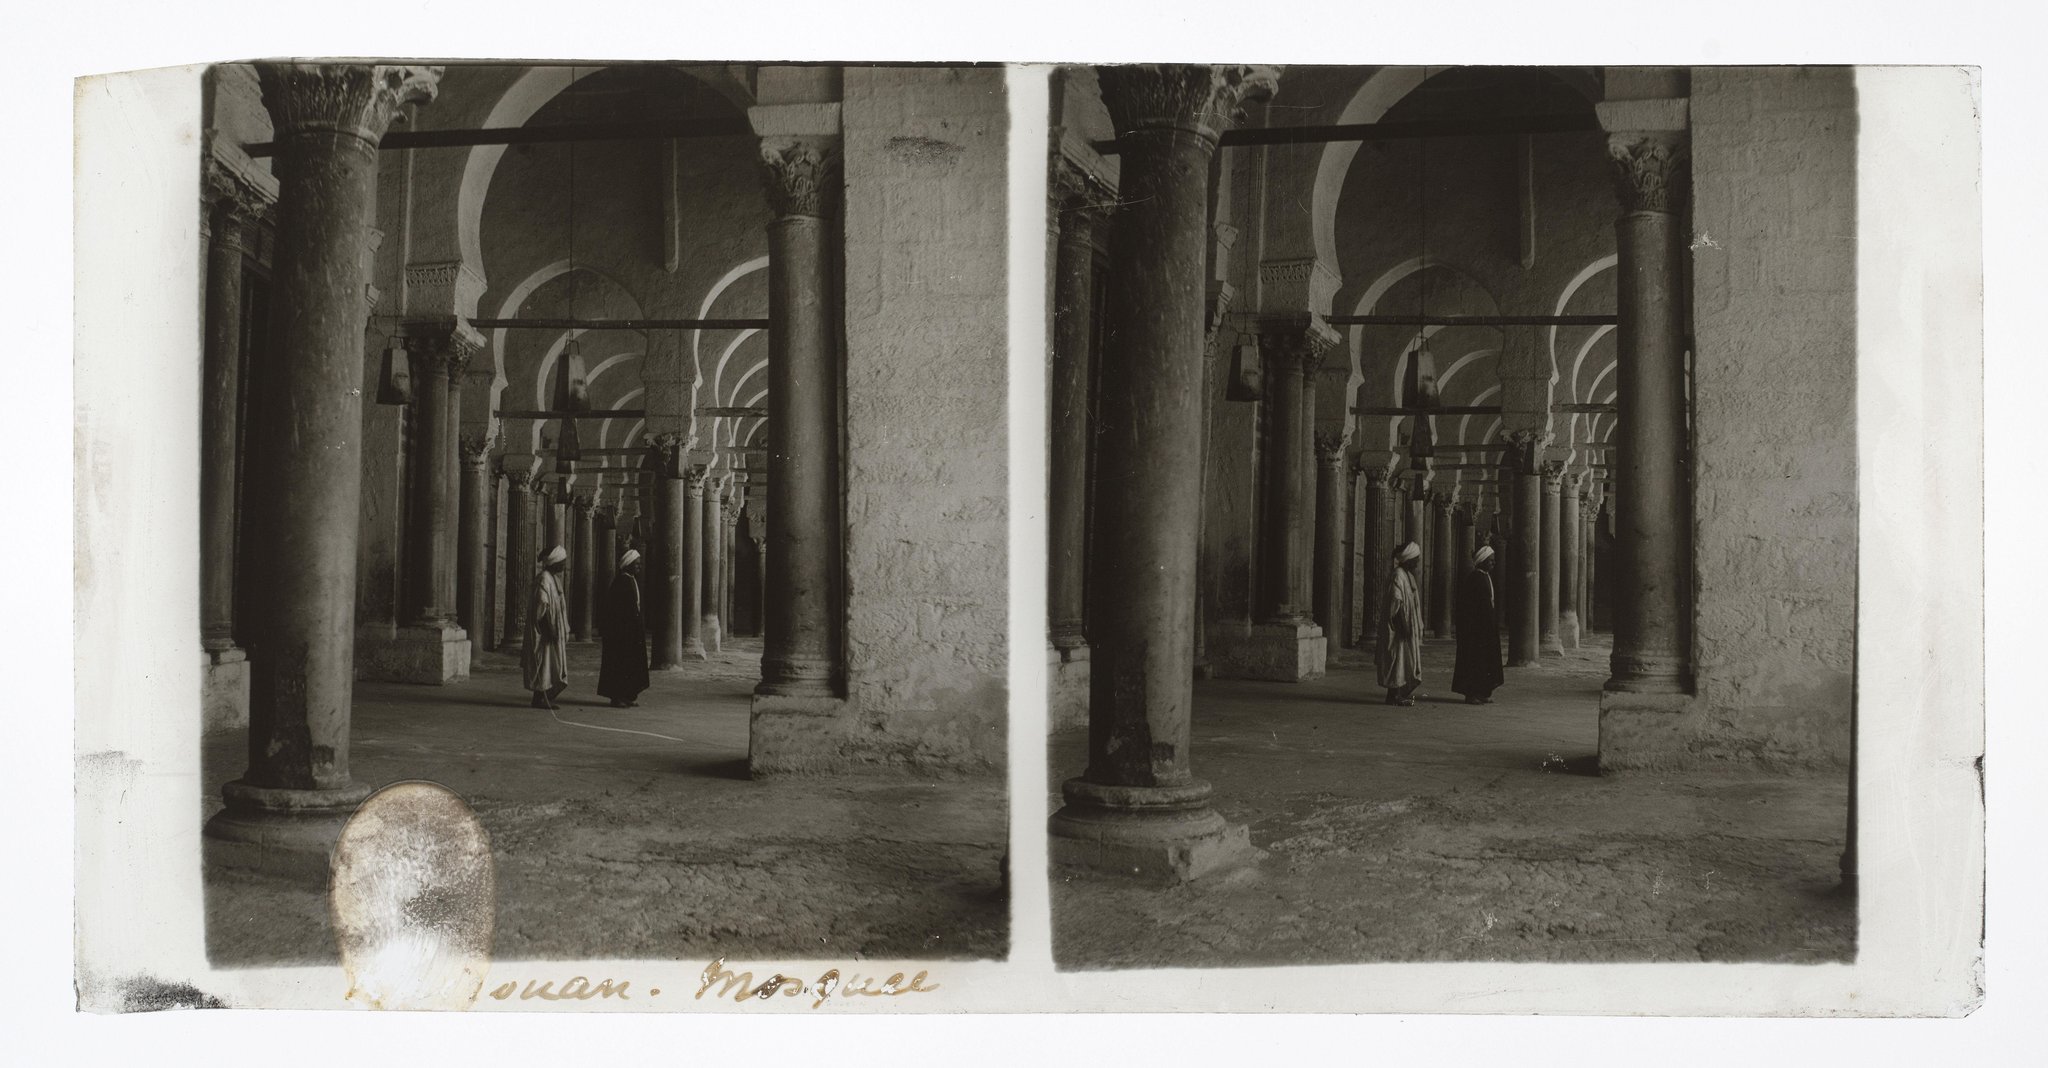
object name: stereoscopic photograph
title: [...]skan Mosque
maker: Anonymous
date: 1890-1910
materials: glass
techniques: slide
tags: temple, shrine ~ islam, mohammedanism